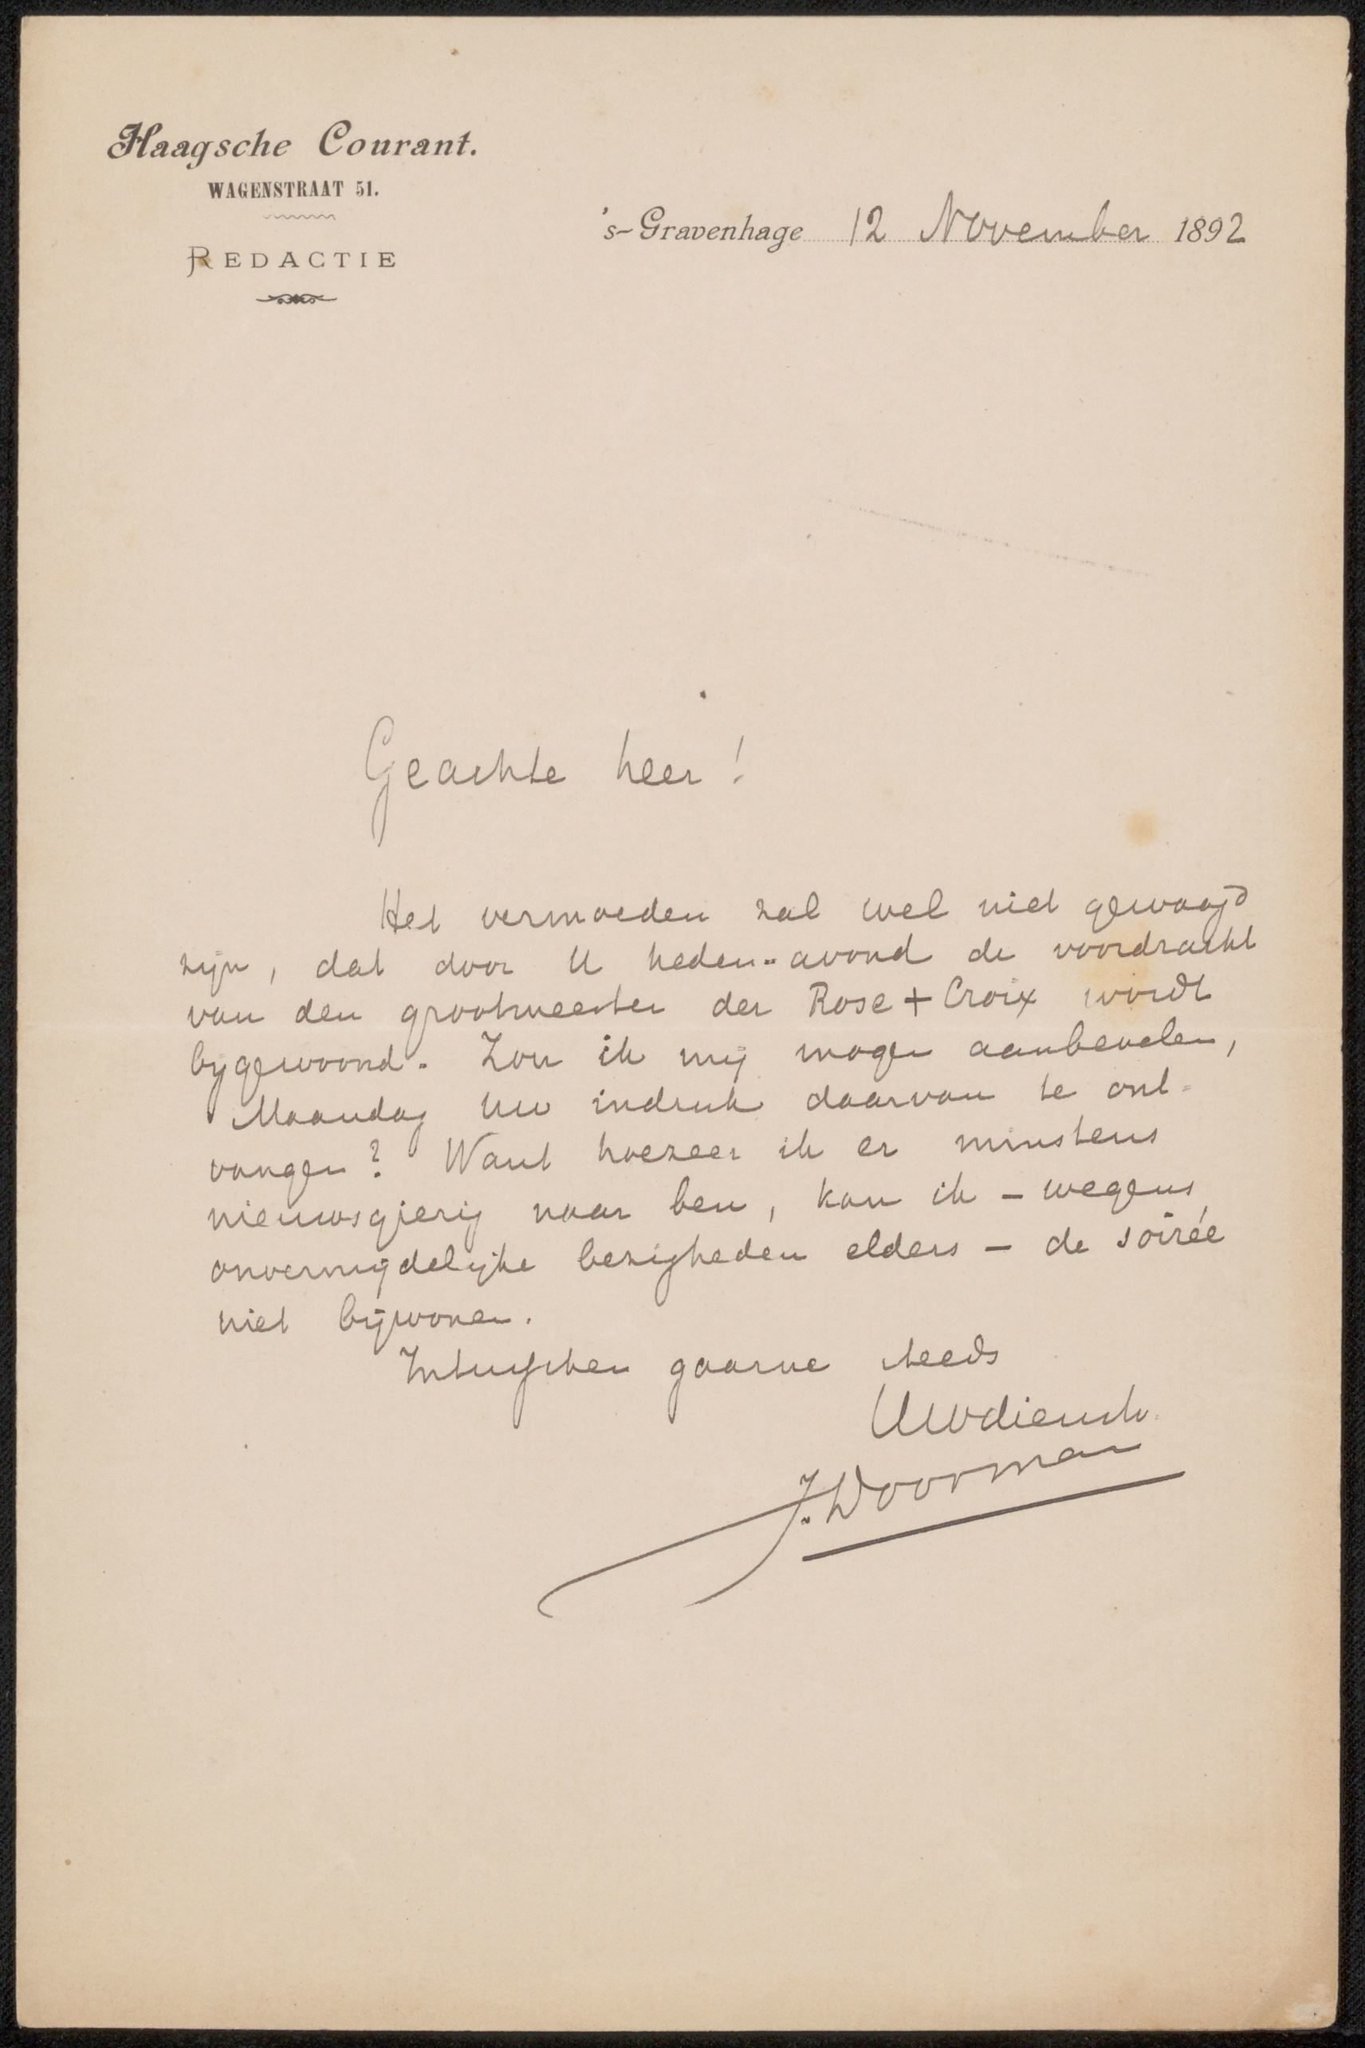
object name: letter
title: Brief aan Philip Zilcken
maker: j. doorman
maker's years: -1913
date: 1892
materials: ink, paper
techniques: pen, printing, writing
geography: the hague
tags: paul verlaine, the hague, painter, draughtsman, philip zilcken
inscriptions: collector's mark: ‘RPK’